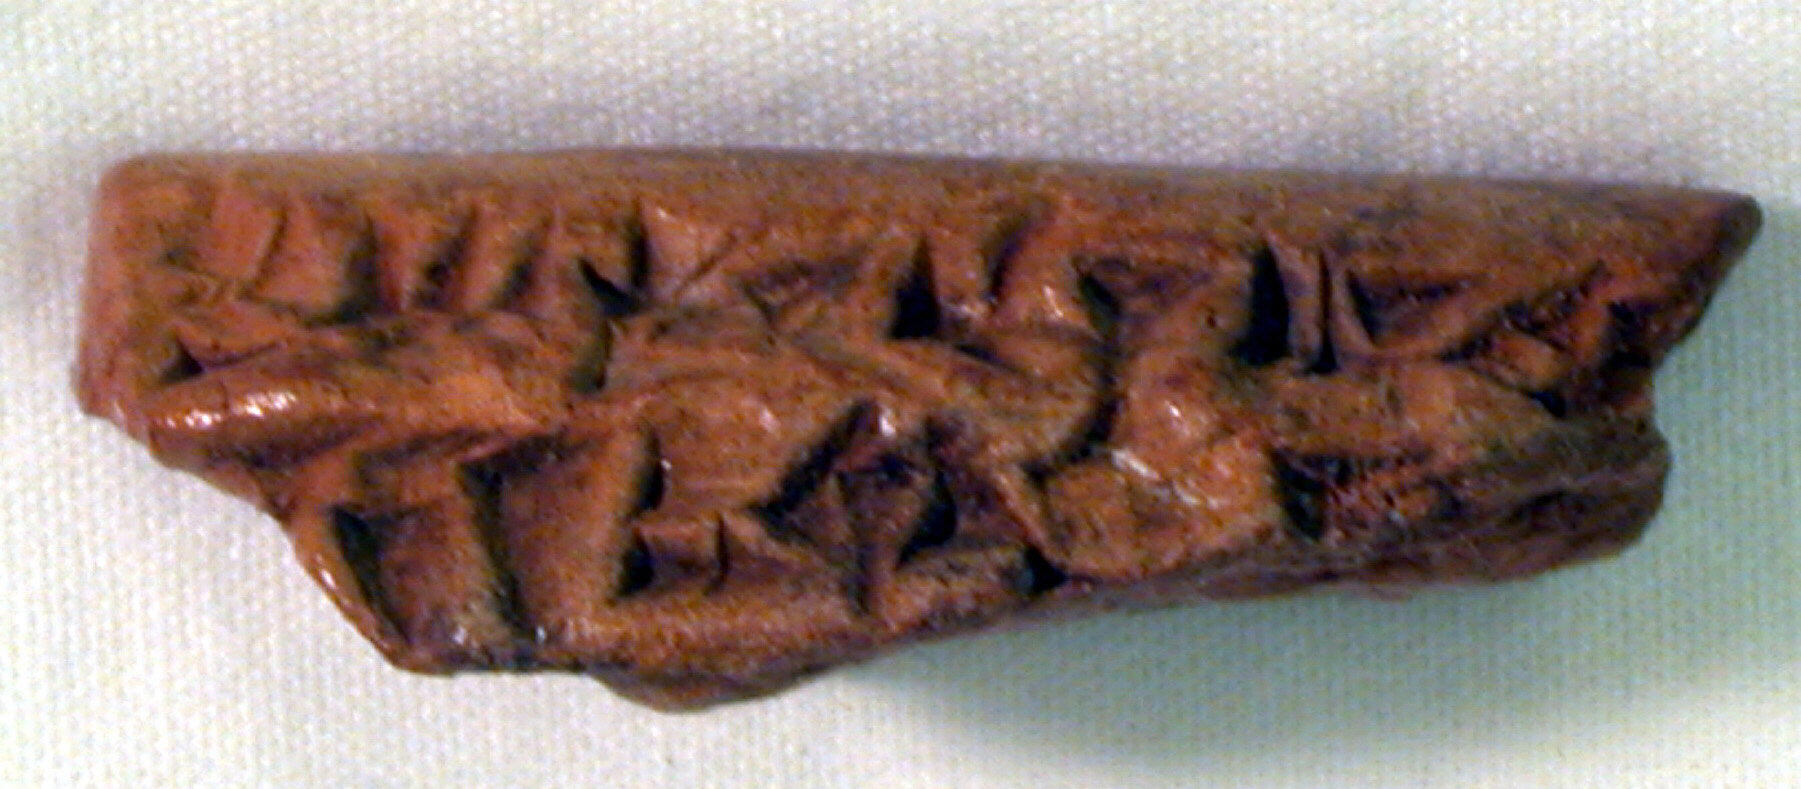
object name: cuneiform tablet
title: Cuneiform tablet: fragment of a promissory note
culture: achaemenid or babylonian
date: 700-301 BCE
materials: clay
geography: mesopotamia